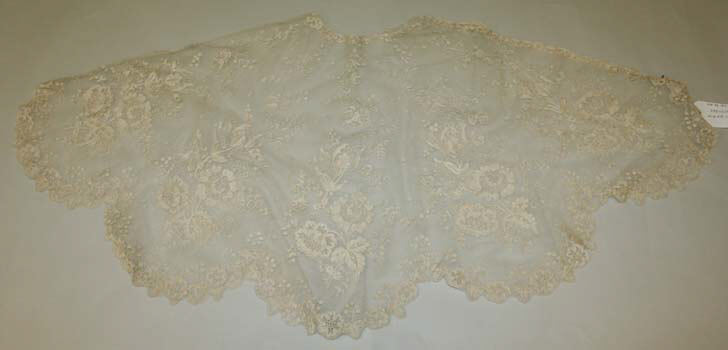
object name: collar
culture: french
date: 1834-1866